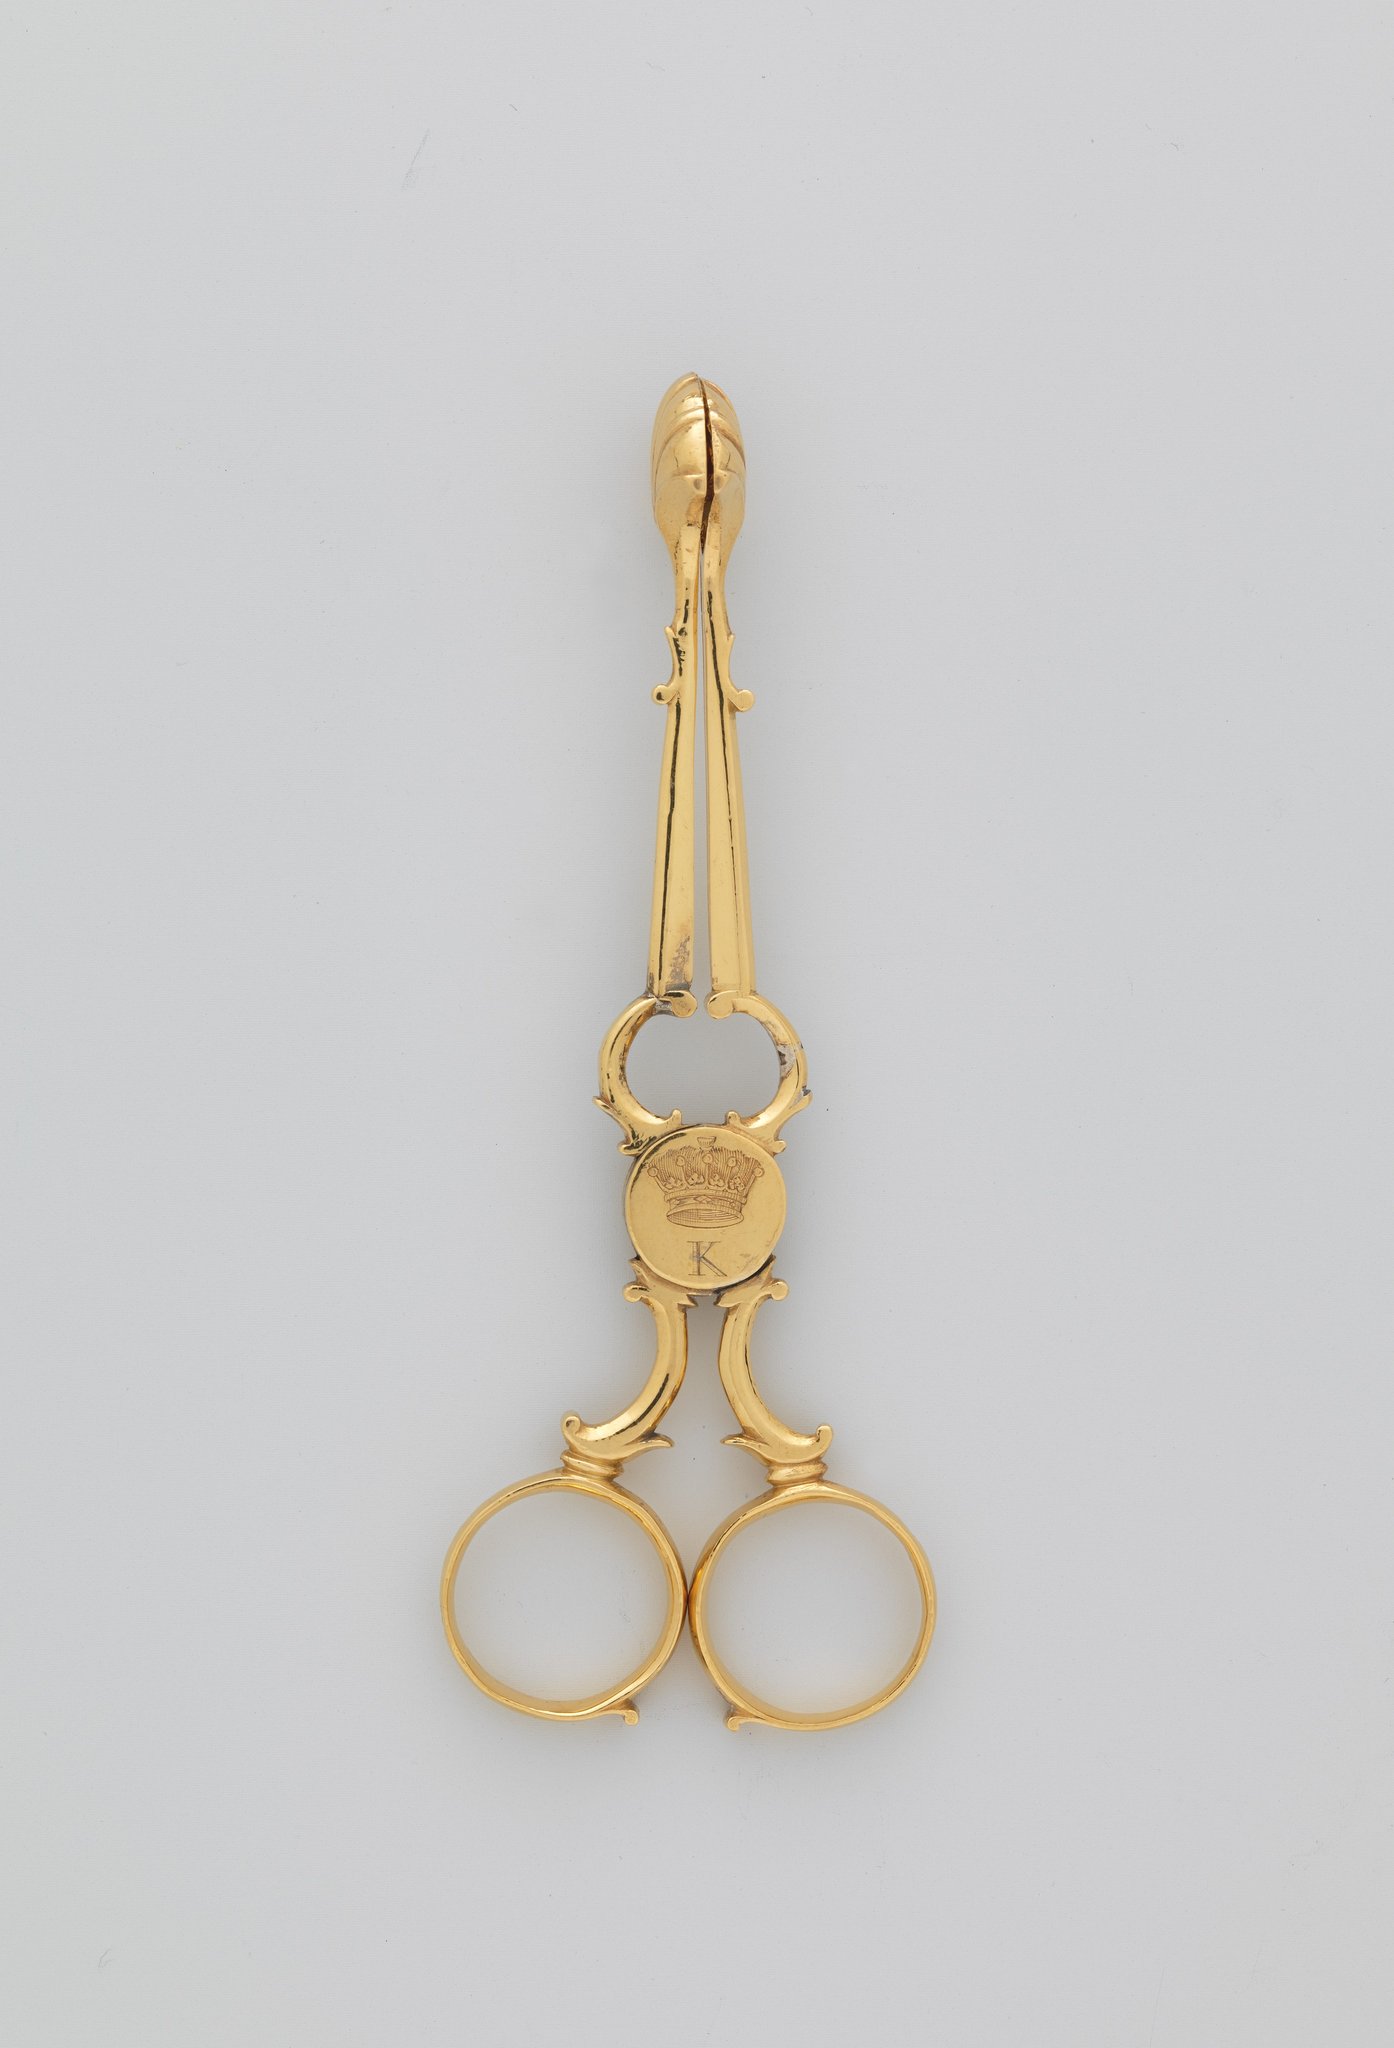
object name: sugar tongs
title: Sugar tongs (part of a set)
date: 1730-1750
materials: gold